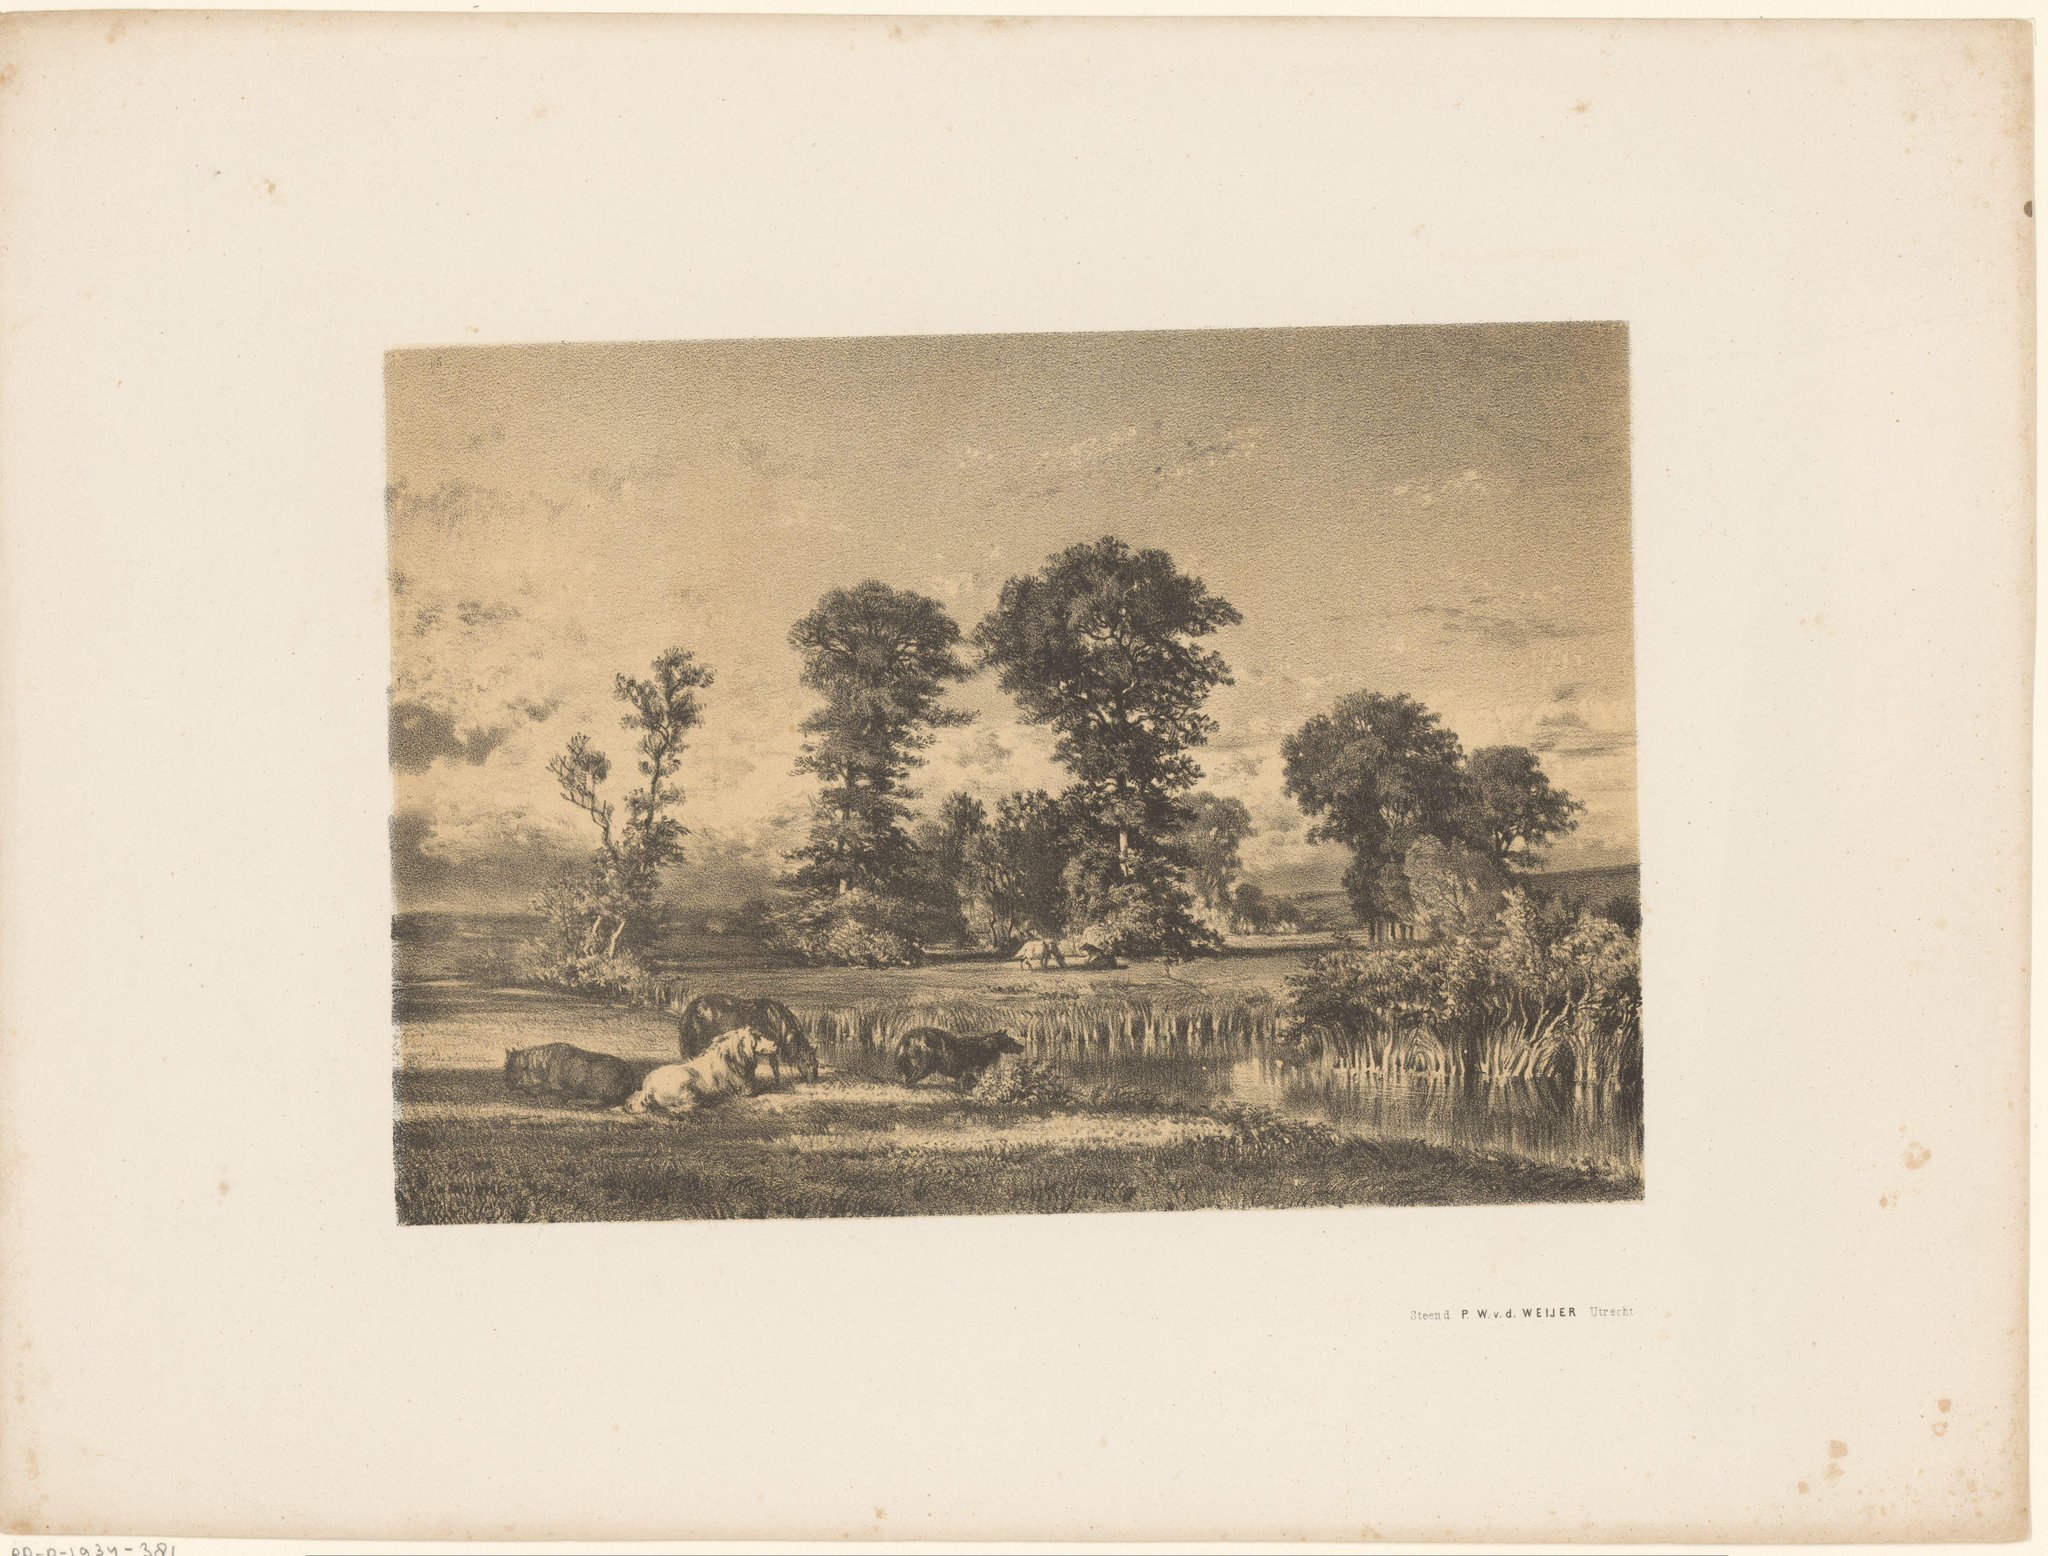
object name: print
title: Weidelandschap met grazende paarden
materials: paper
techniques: tone lithography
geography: utrecht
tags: meadow, pasture, horse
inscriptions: collector's mark: Lugt 2228